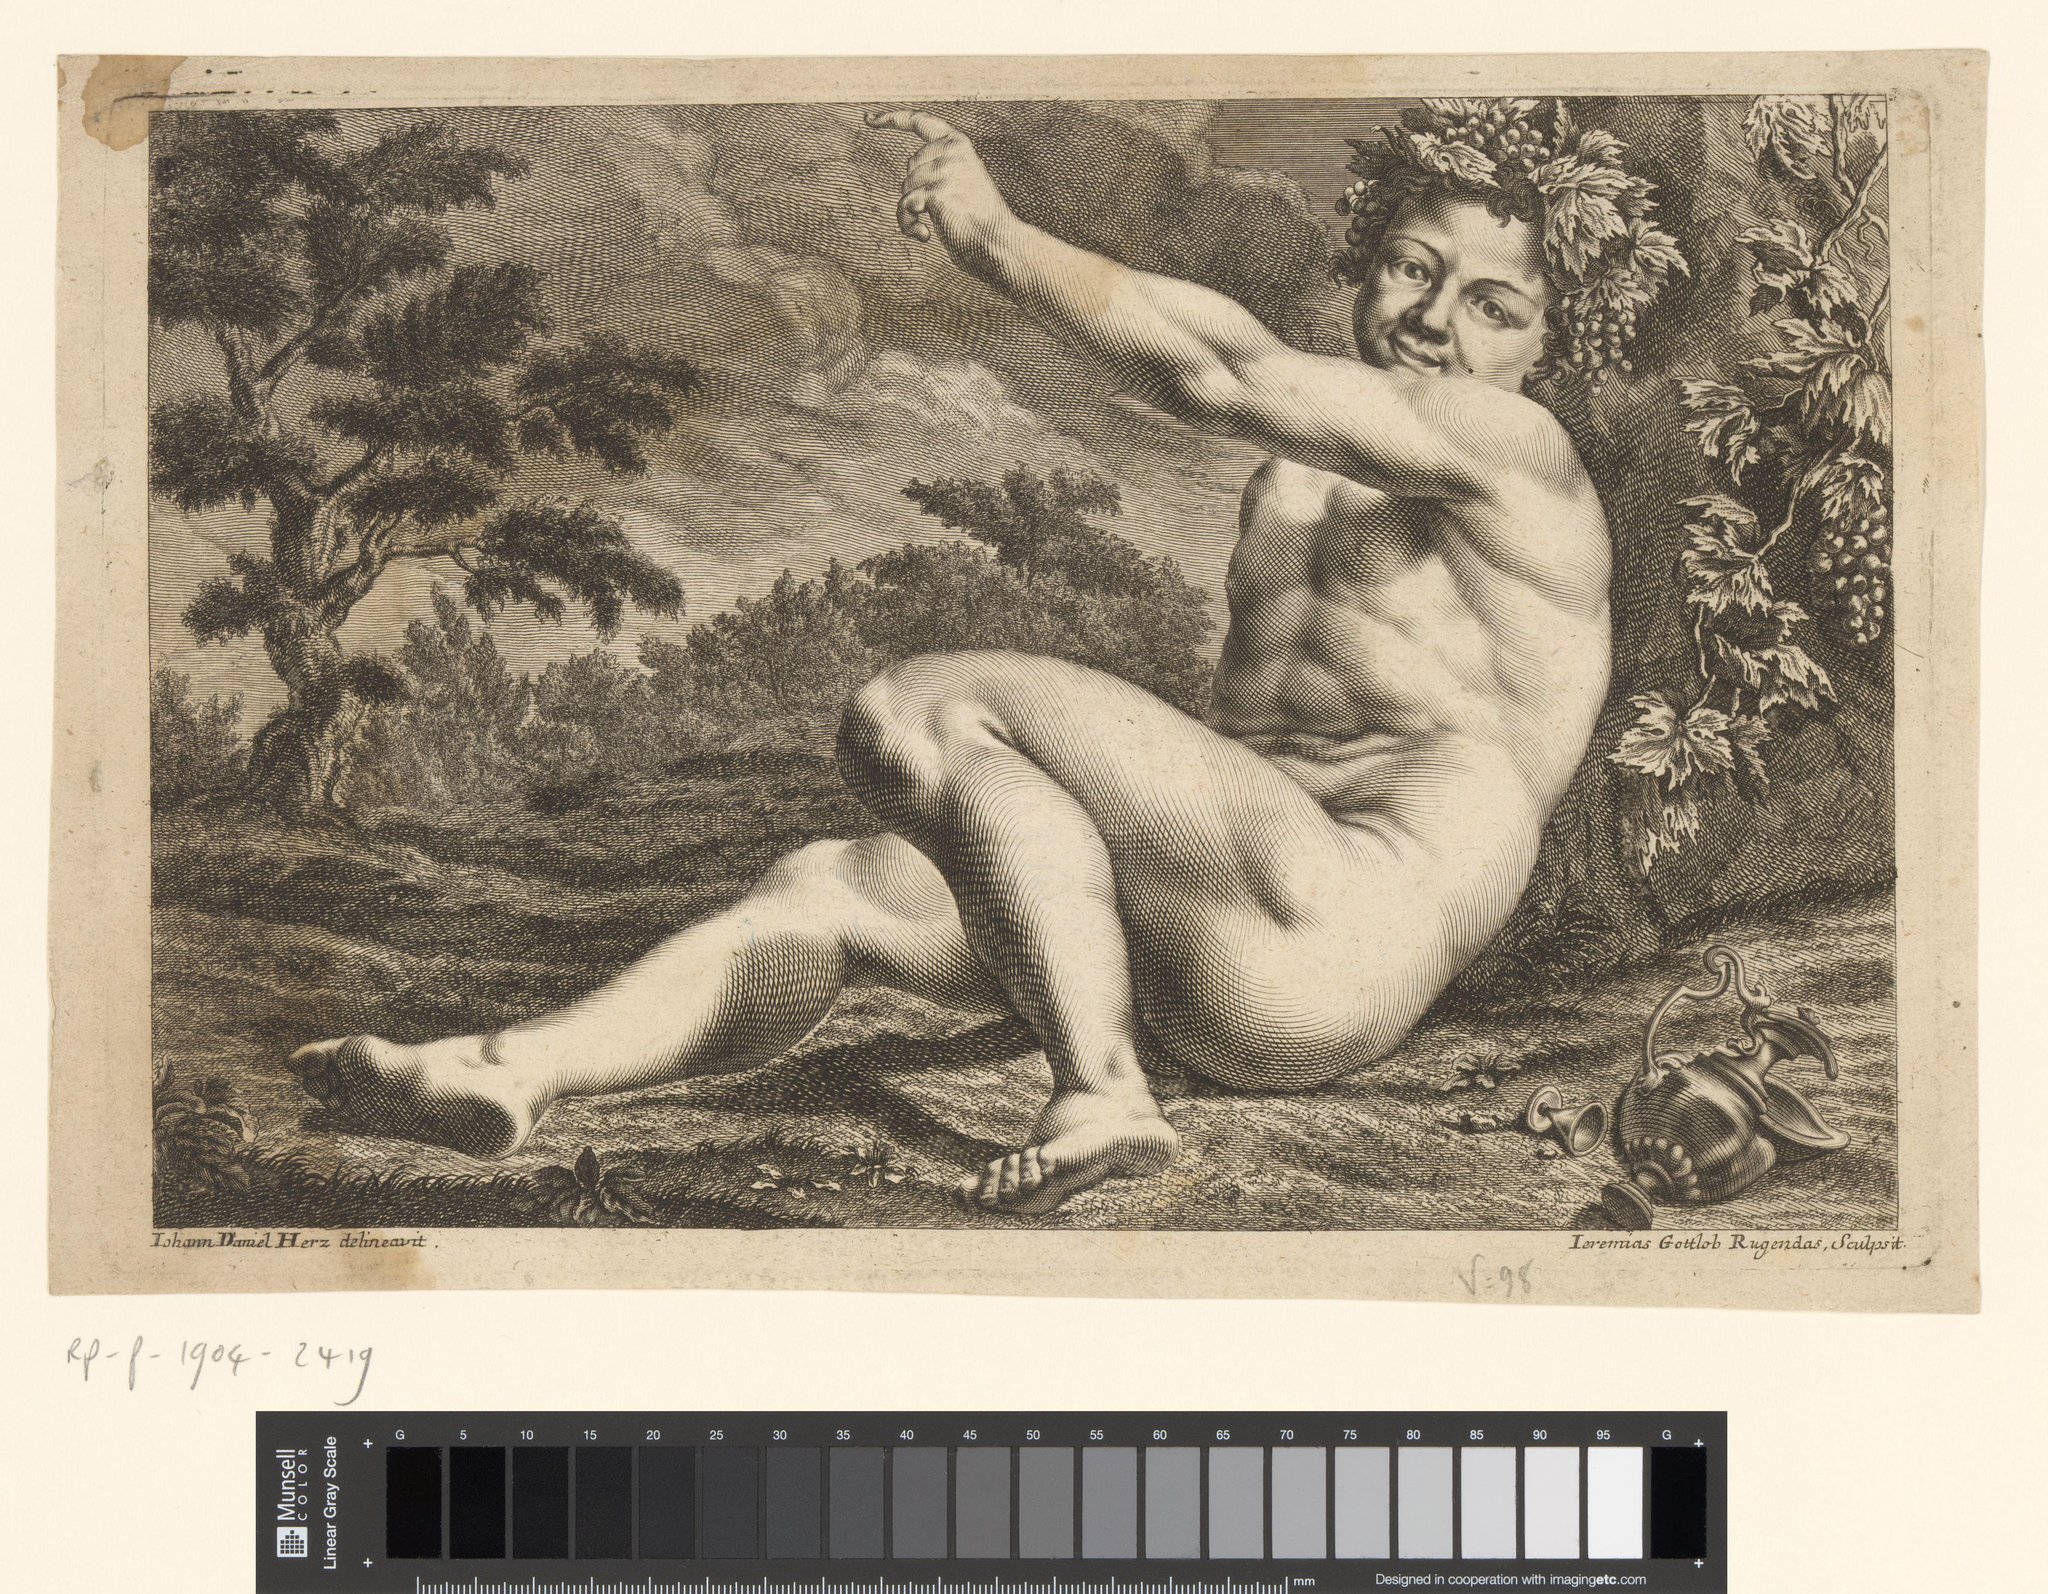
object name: print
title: Jonge Bacchus naakt in een landschap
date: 1723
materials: paper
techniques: engraving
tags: landscapes, (story of) bacchus (dionysus), liber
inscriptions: collector's mark: Lugt 2228, number: ‘V=98’